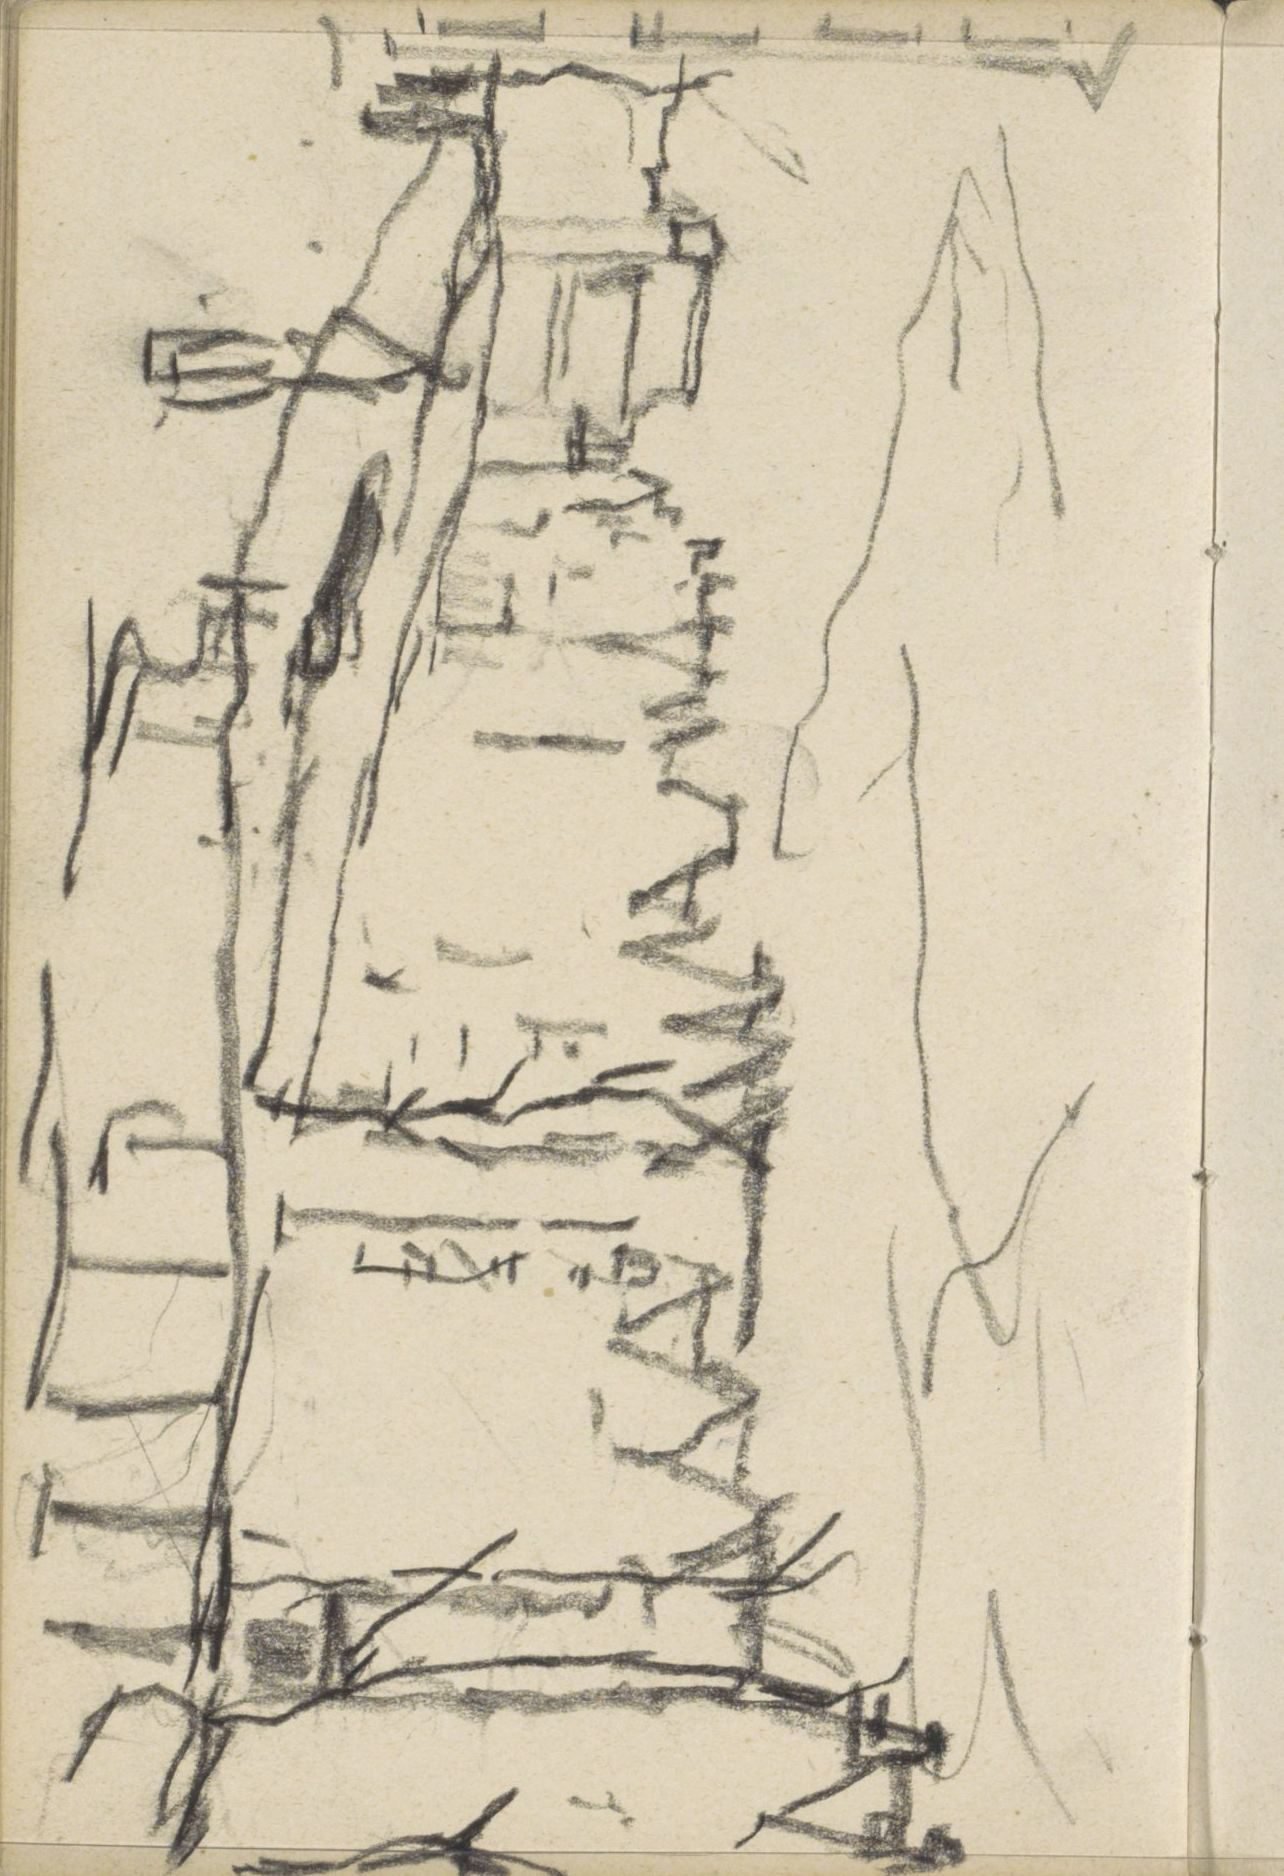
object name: sketchbook leaf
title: Gezicht op het Rokin te Amsterdam vanaf het Spui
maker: george hendrik breitner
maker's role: draughtsman, painter, print maker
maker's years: 1857-1923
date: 1909-1912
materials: chalk, paper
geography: amsterdam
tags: urban housing, canals, waters (in city)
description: Gezicht op het Rokin te Amsterdam vanaf het Spui. Pagina 79 uit een schetsboek met 46 bladen vervaardigd te Amsterdam.